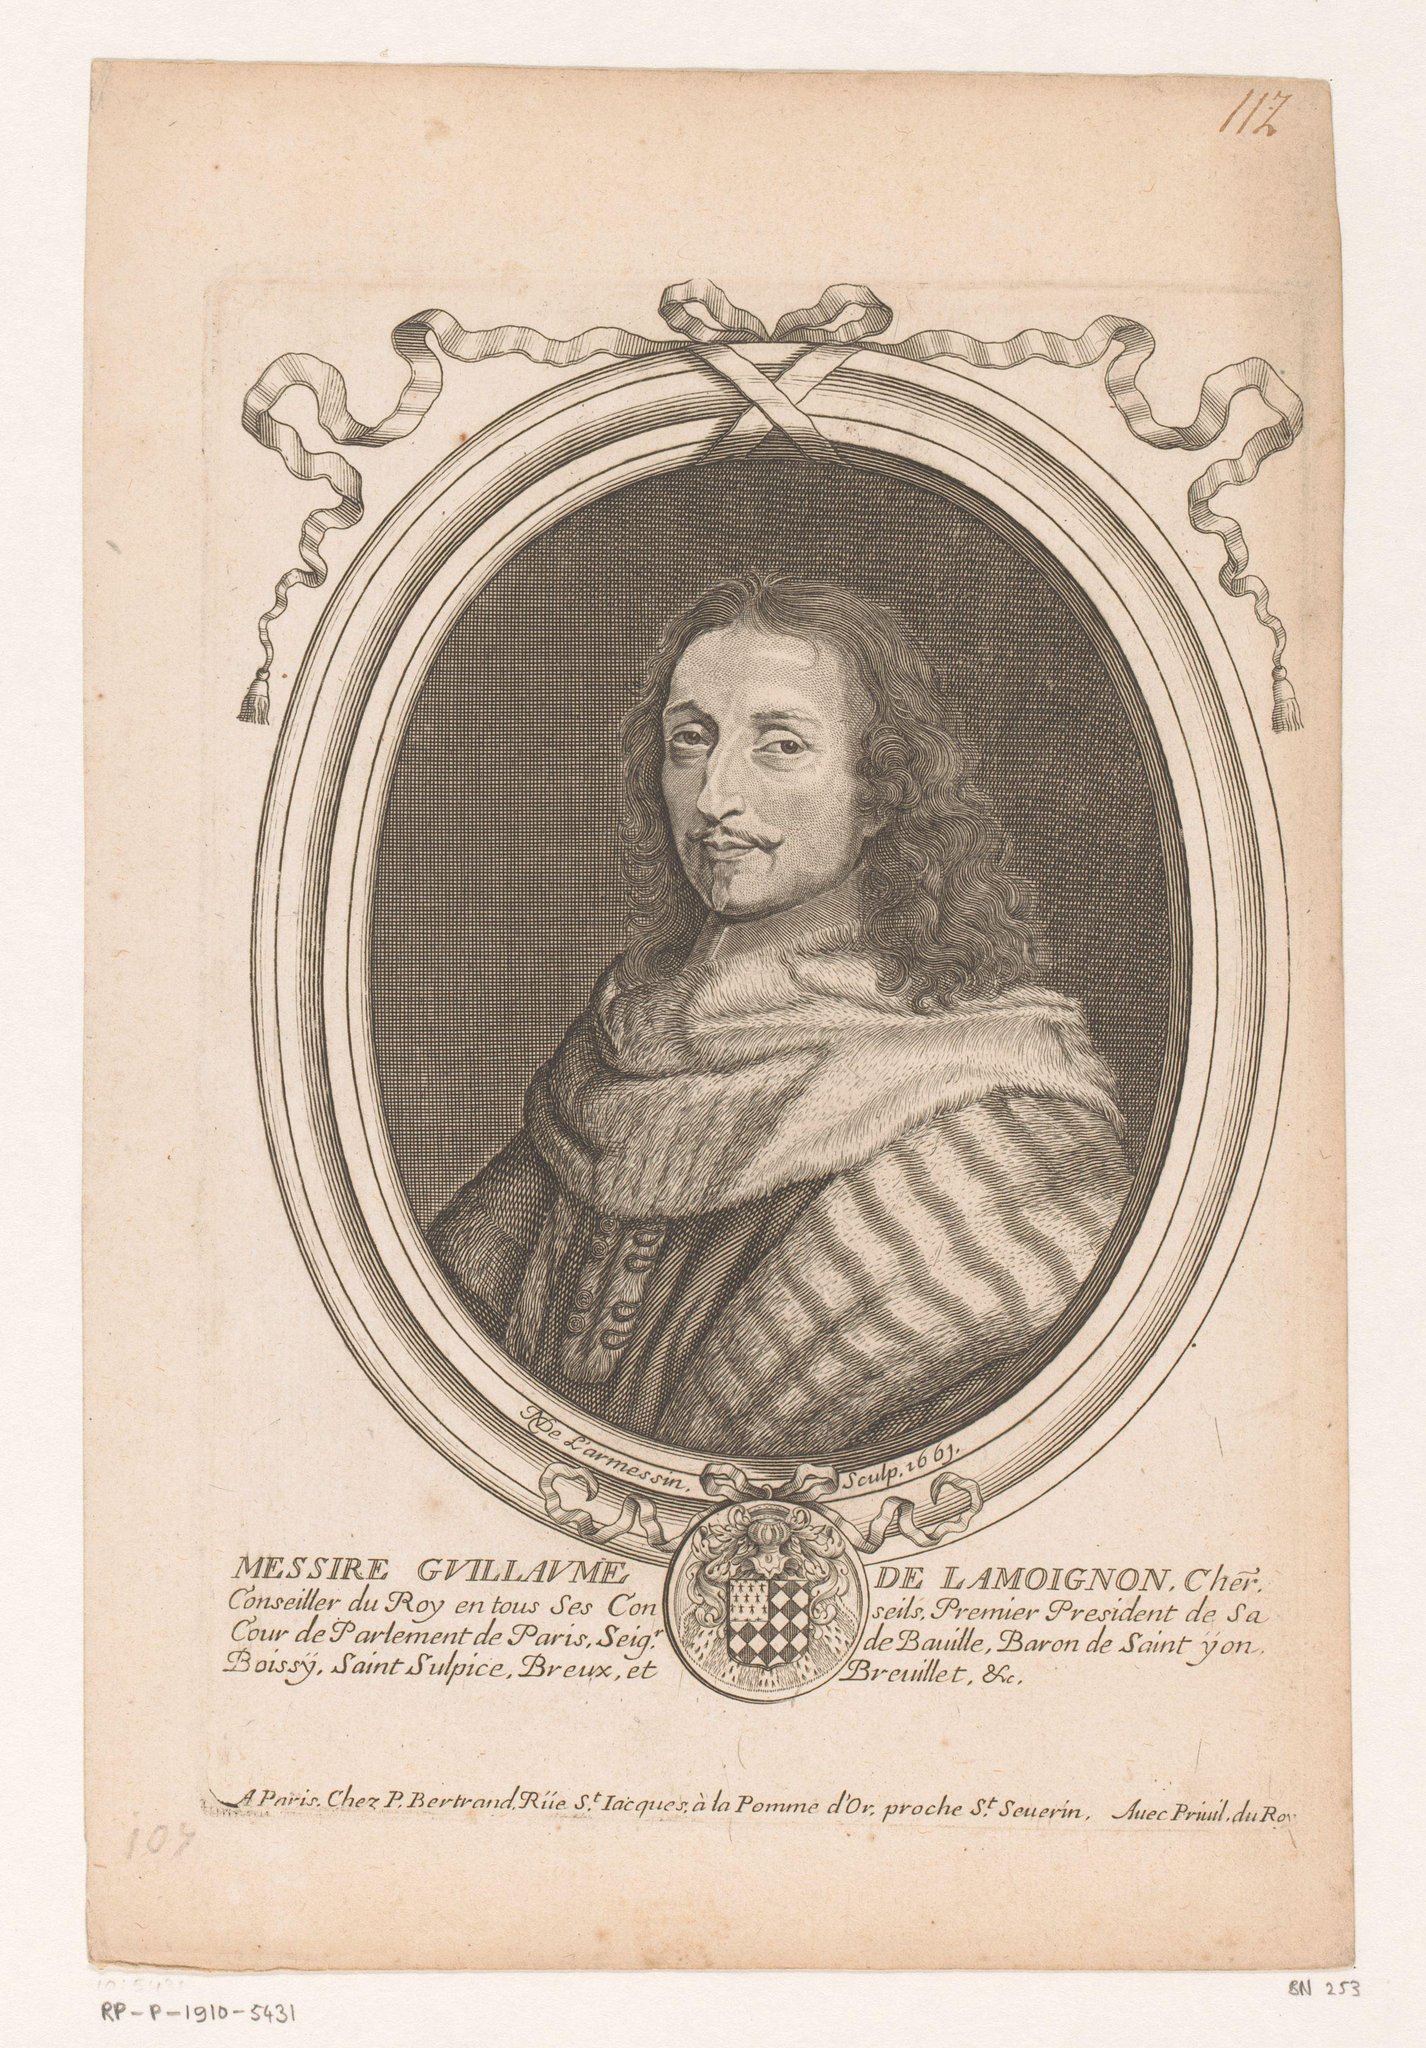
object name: print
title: Portretten van prominente figuren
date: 1661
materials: paper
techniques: engraving, etching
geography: france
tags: historical persons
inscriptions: collector's mark: Lugt 2228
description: Maakt deel uit van een grootschalige serie met portretten van prominente figuren. Binnen de serie bevindt zich een sectie getiteld 'Les Augustes Représentations De tous les Roys De France depuis Pharamond Iusqu'à Louys XIIII'. De serie werd respectievelijk uitgegeven door Pierre Bertrand, door zijn weduwe en door De Larmessin zelf.